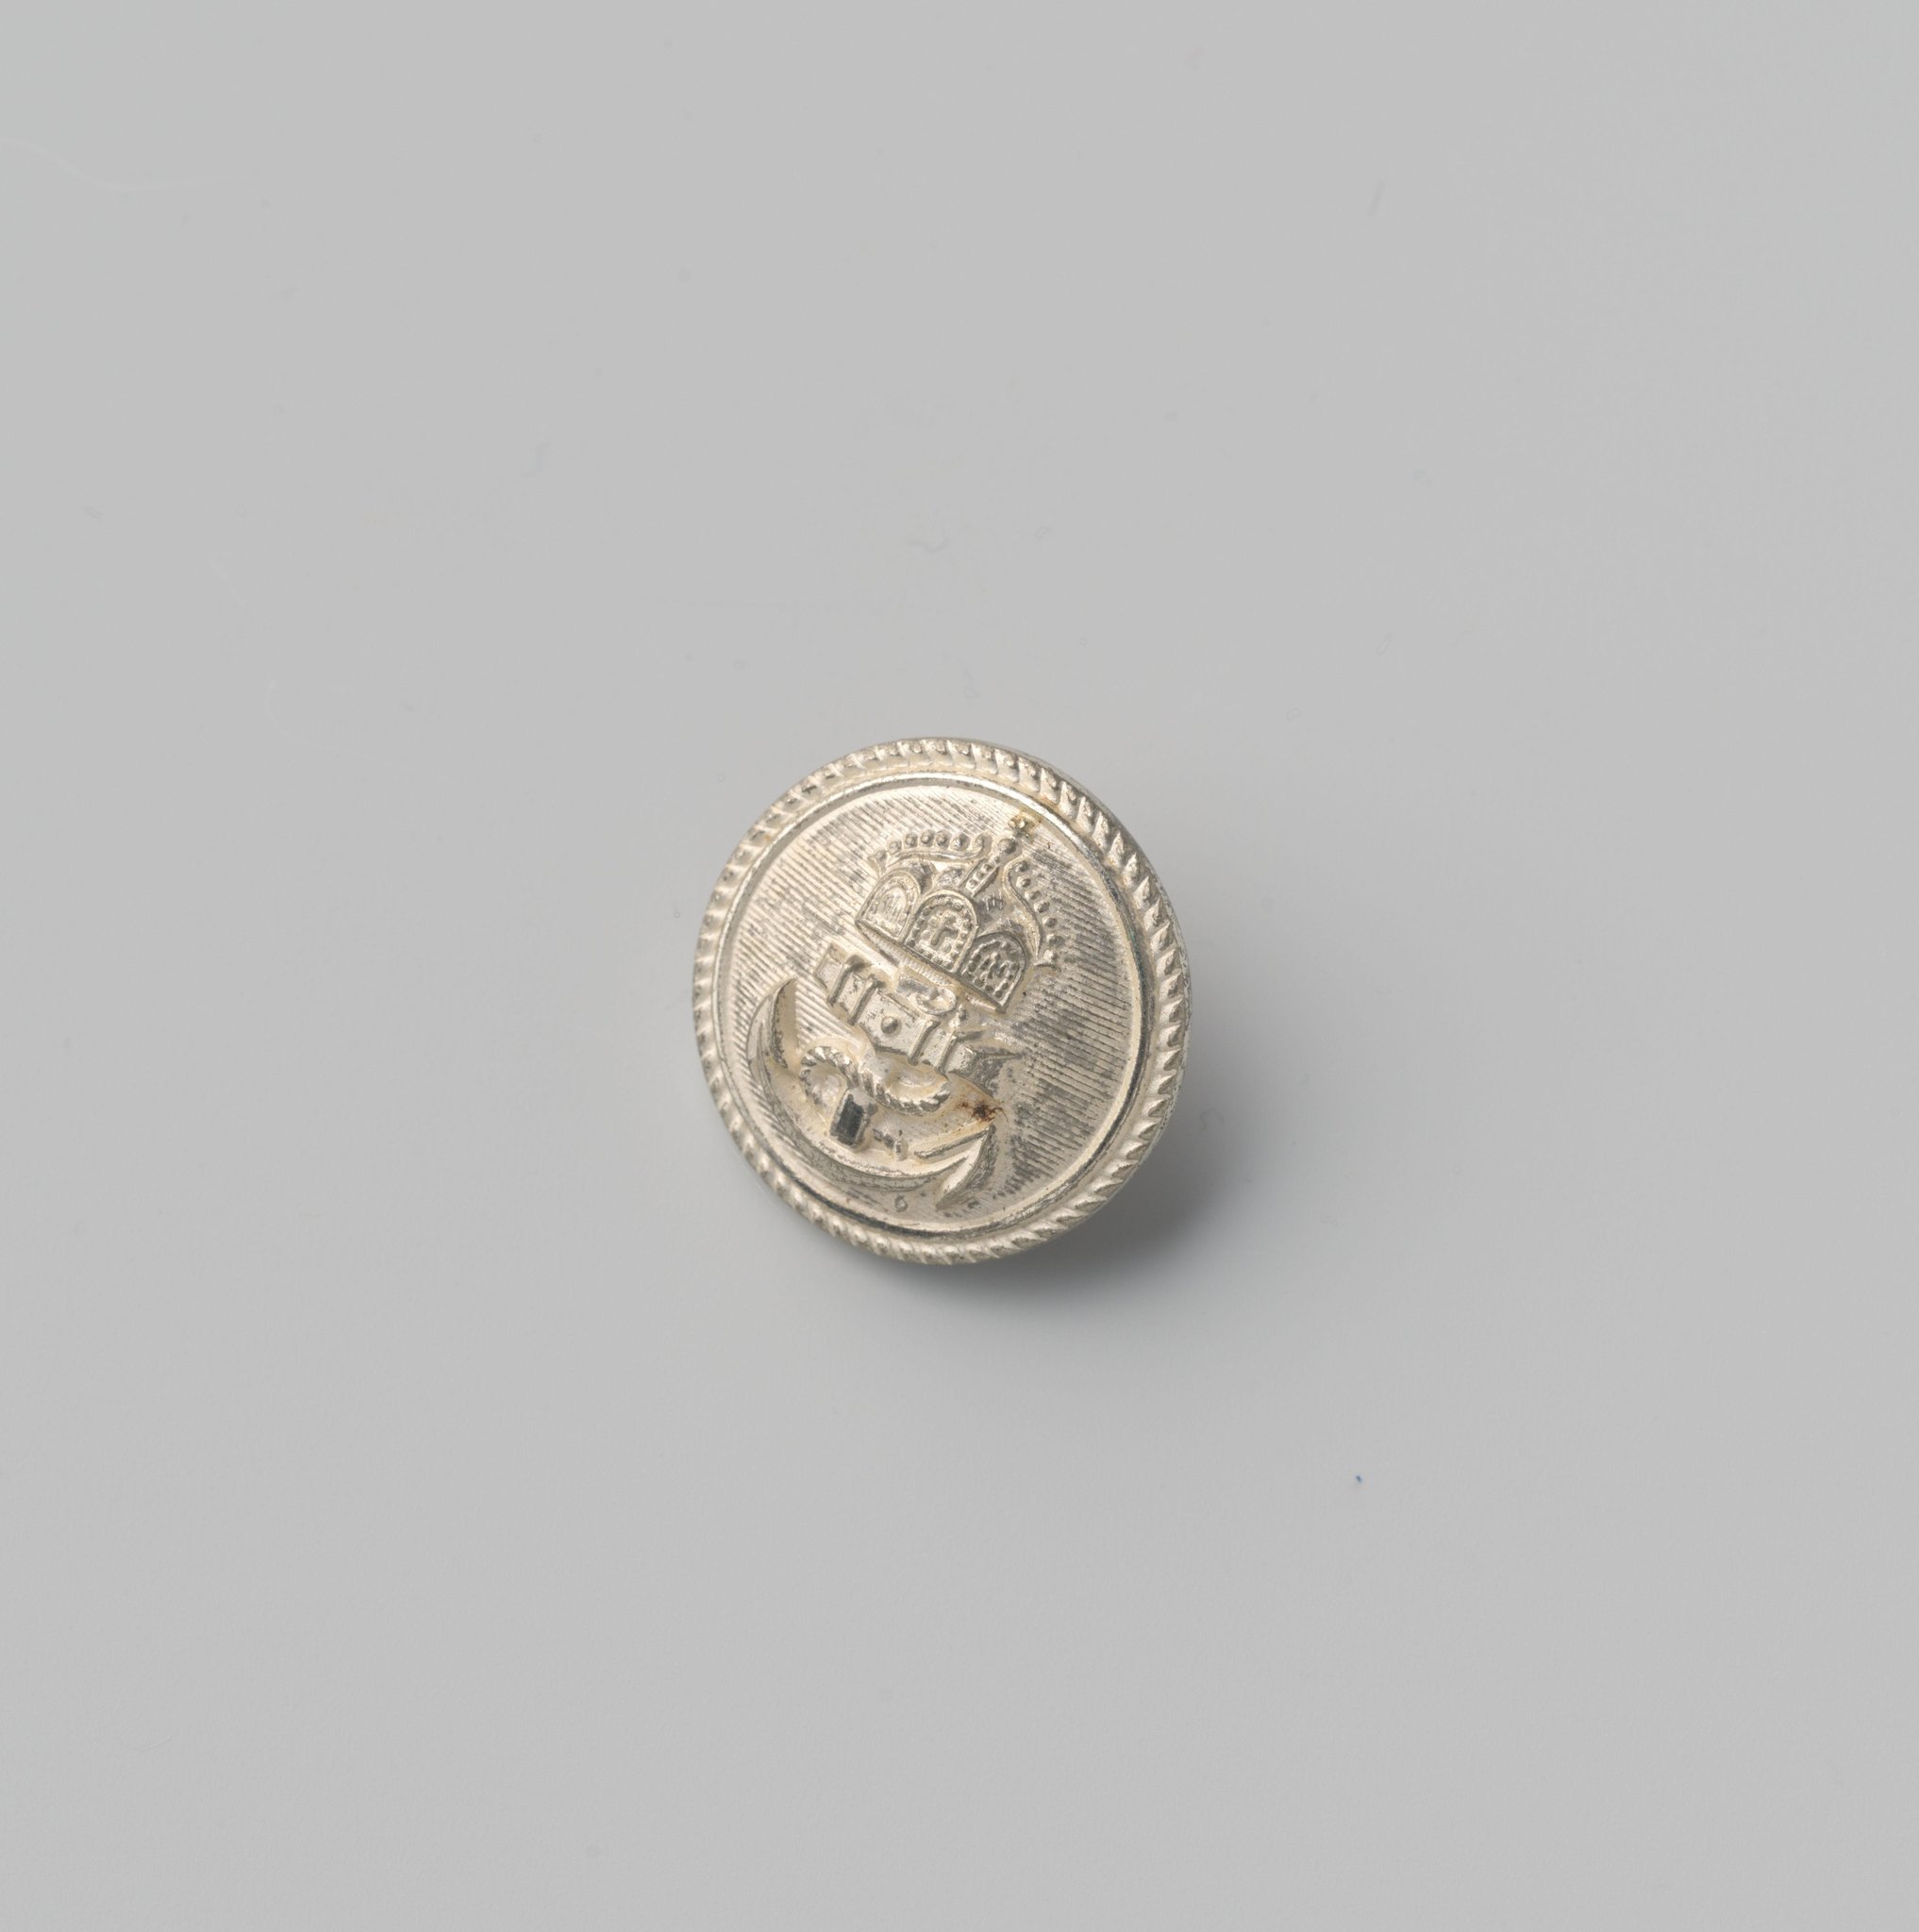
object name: button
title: Knoop van de Duitse keizerlijke marine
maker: Anonymous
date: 1900-1925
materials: metal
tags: eugen wachenheimer, else wachenheimer-moos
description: Dit object is onderdeel van de nalatenschap van Isabel Elon-Wachenheimer (1928-2010). Tot haar overlijden behoorde het samen met de andere objecten uit de nalatenschap tot haar privédomein van Isabel Wachenheimer. In die particuliere context zijn deze objecten tezamen en individueel aandenkens - aan de jeugd, ouders en familie van Isabel Wachenheimer vóór en tijdens de Shoah en aan haar leven na de Tweede Wereldoorlog. Isabel Wachenheimer, die van juni 1943 tot mei 1945 gevangen zat in Kamp Westerbork, Theresienstadt, Auschwitz, Lenzing a/d Oberdonau (een buitenkamp van Mauthausen), overleefde de Shoah. Haar ouders – Eugène Wachenheimer en Else Wachenheimer-Moos - werden op 14 oktober 1944 in Auschwitz-Birkenau vermoord.